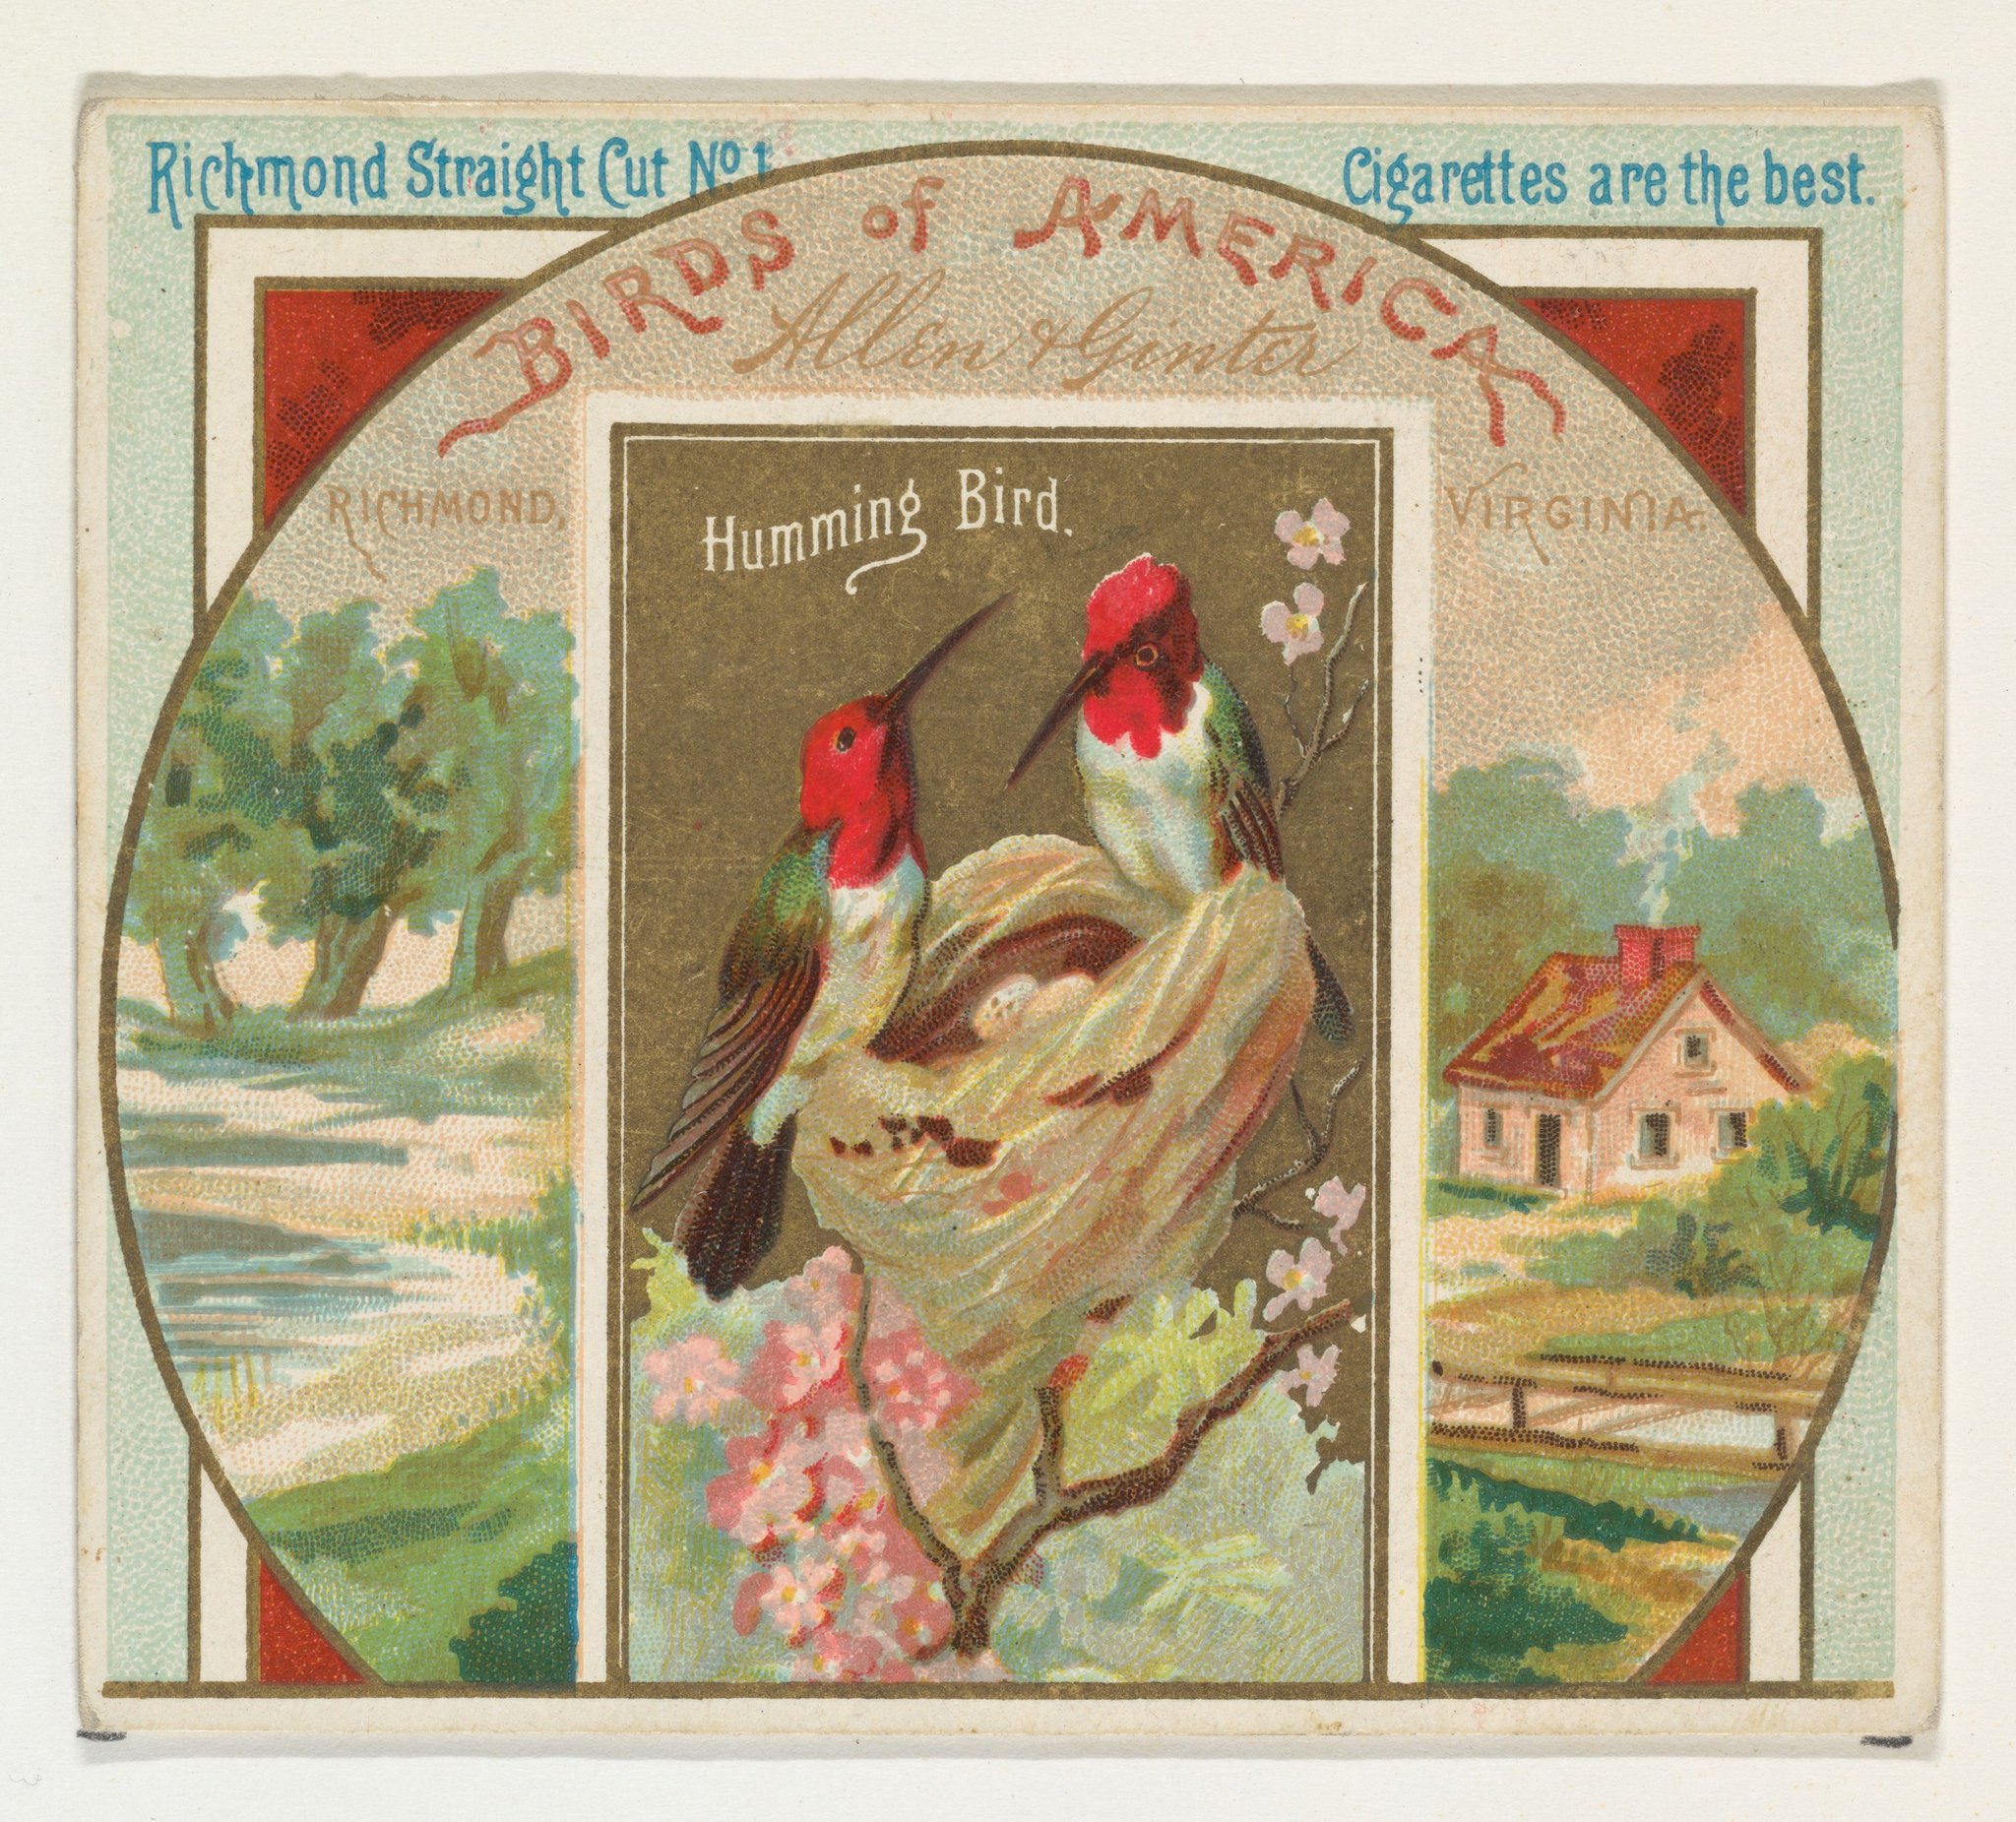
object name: print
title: Hummingbird, from the Birds of America series (N37) for Allen & Ginter Cigarettes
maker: allen & ginter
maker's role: publisher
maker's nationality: american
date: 1888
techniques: color lithograph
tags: birds